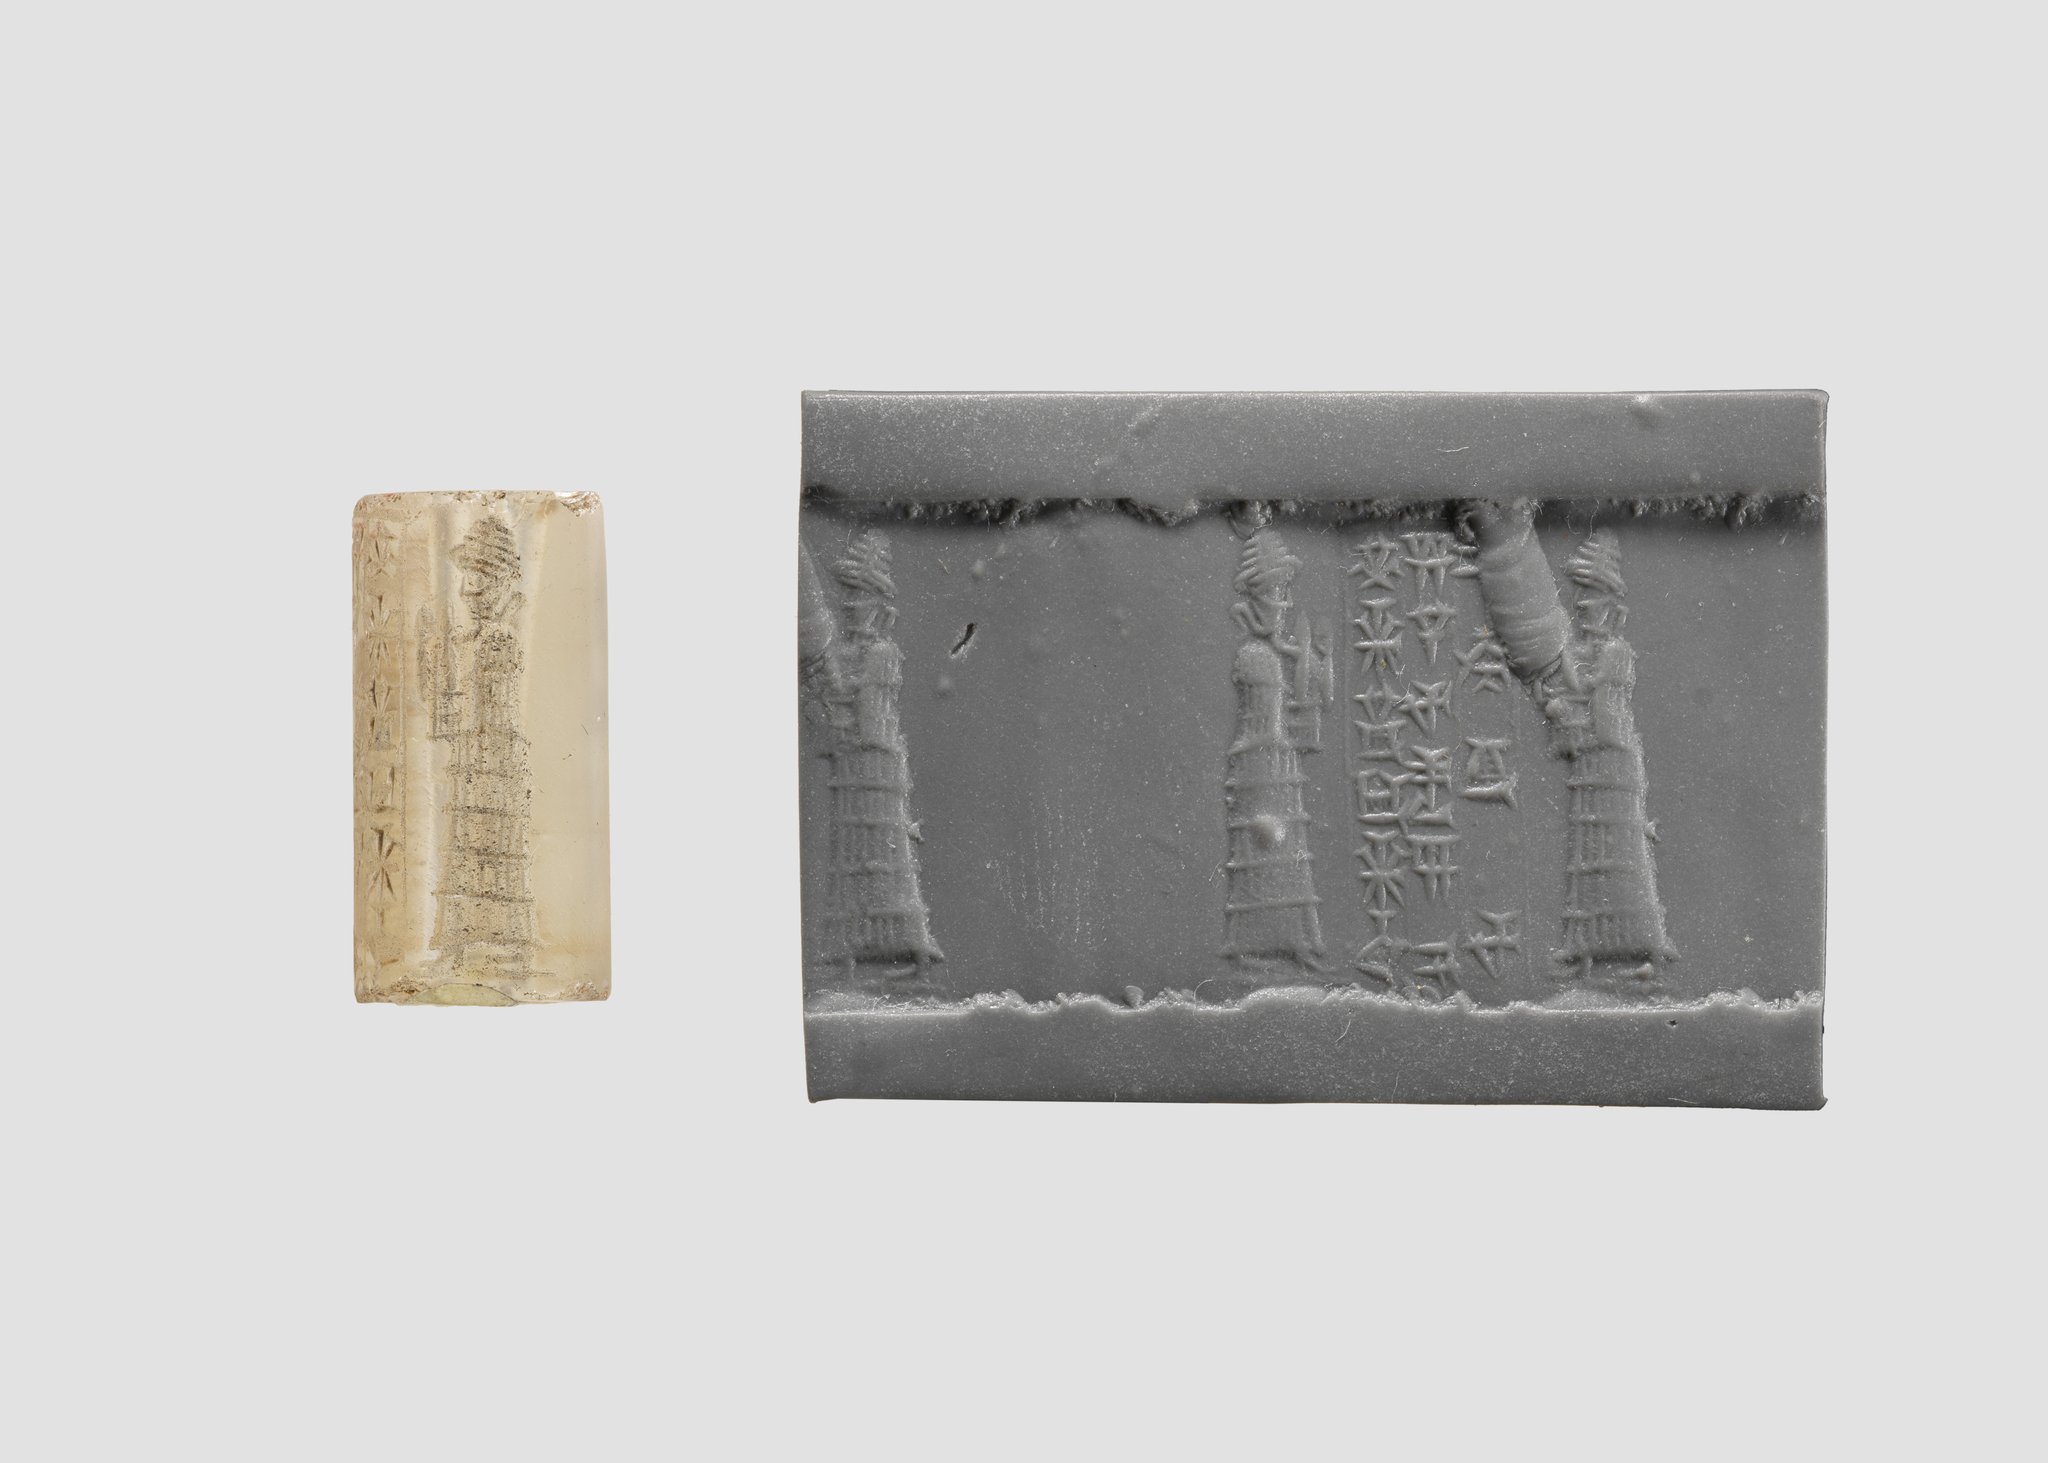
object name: cylinder seal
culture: babylonian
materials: quartz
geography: mesopotamia